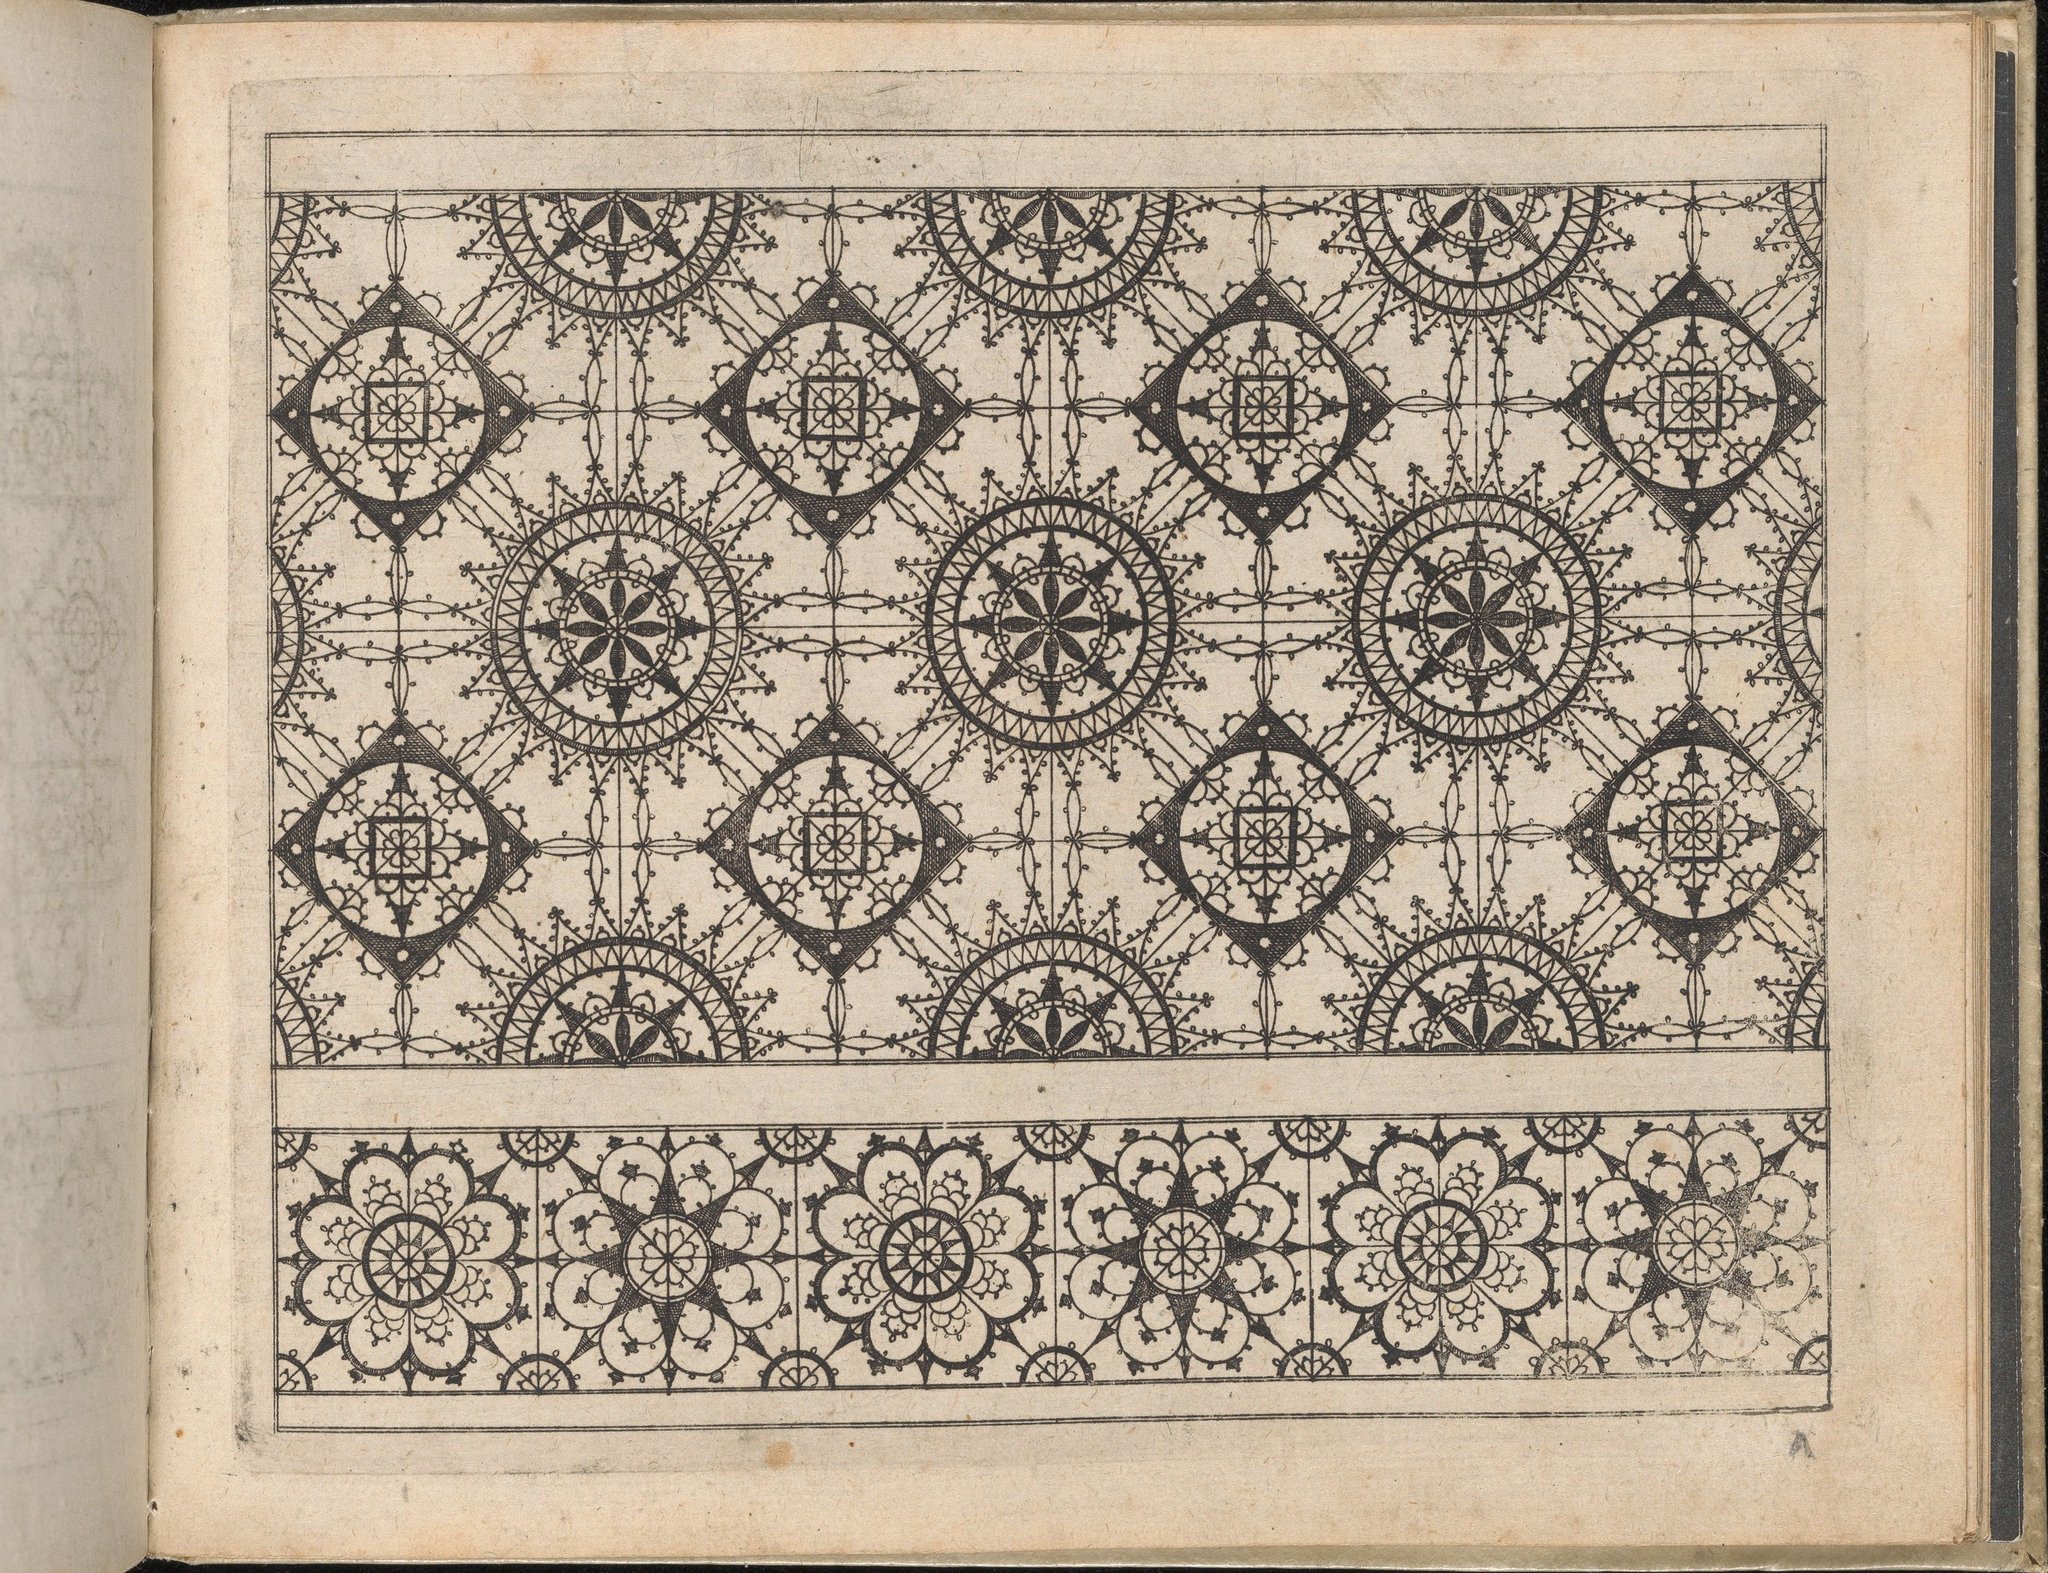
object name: book print ornament architecture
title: Newes Modelbuch in Kupffer (Page 57r)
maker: johann sibmacher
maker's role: artist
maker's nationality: german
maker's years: 1590-1611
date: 1604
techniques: etching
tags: ornament